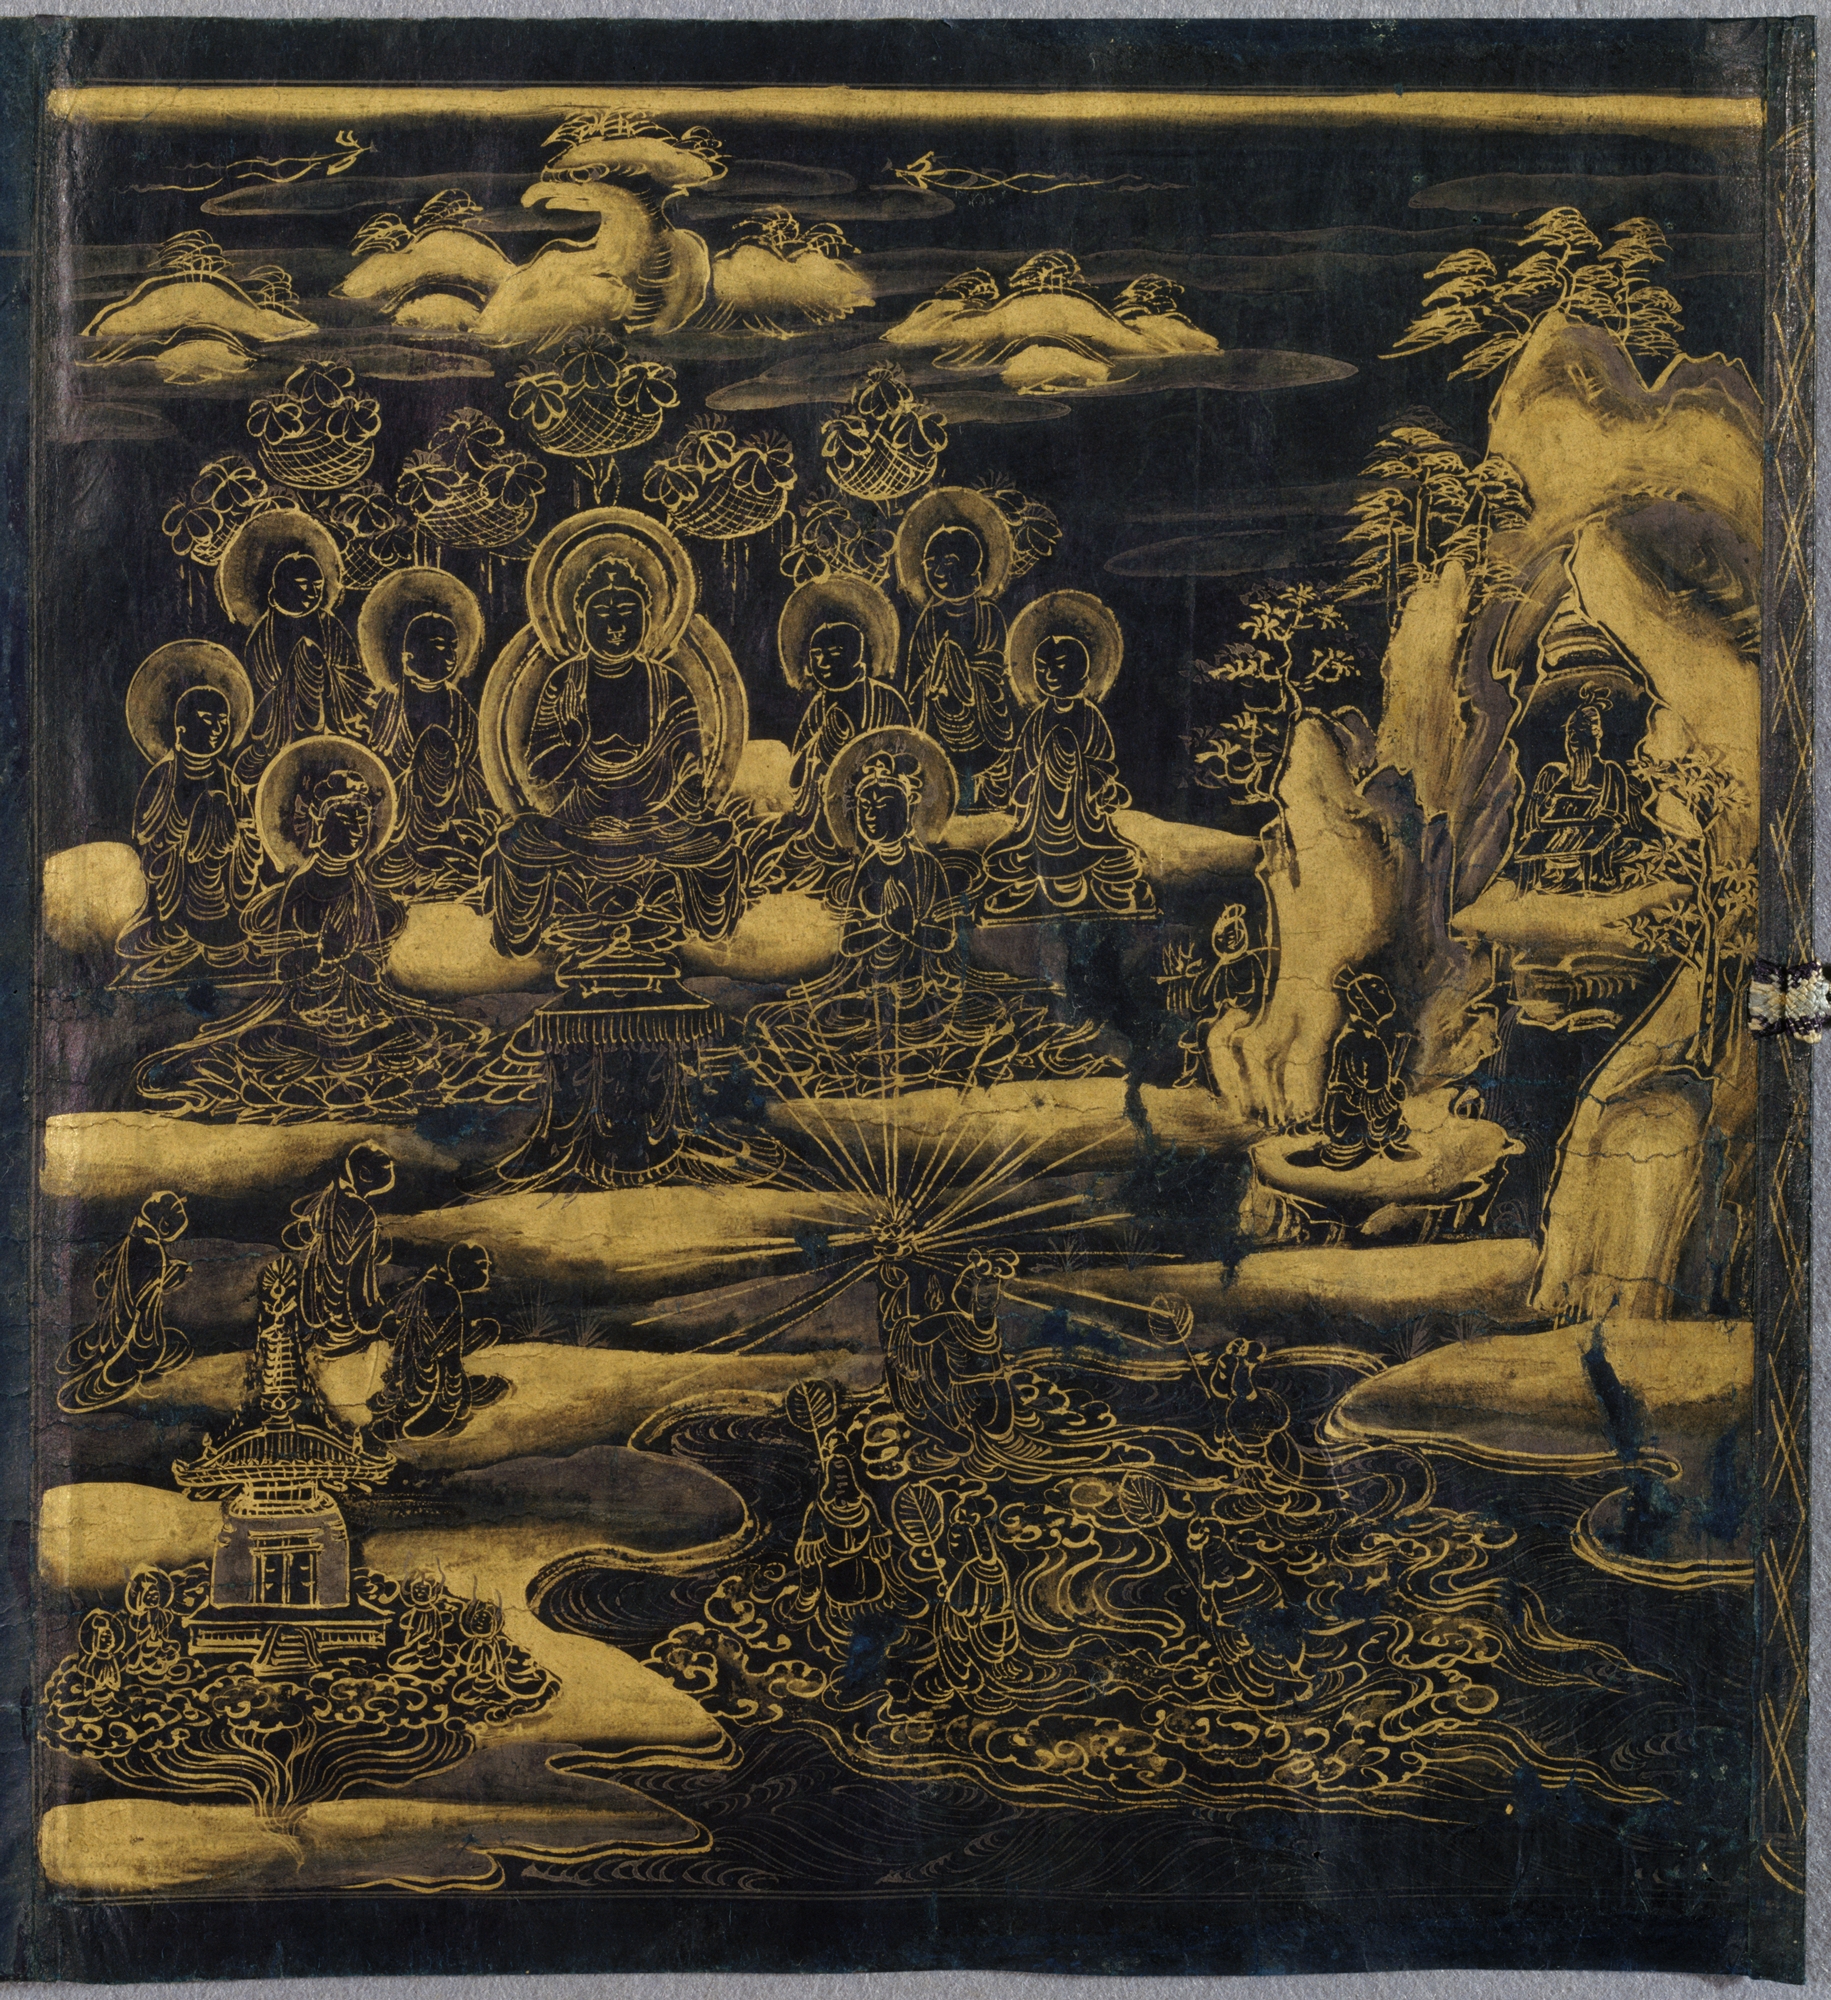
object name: handscroll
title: “Devadatta,” Chapter 12 of the Lotus Sutra (Hoke-kyō, Daibadatta-bon)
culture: japanese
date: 1101-1200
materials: gold, paper, silver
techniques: dyeing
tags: girls,buddhism,buddha